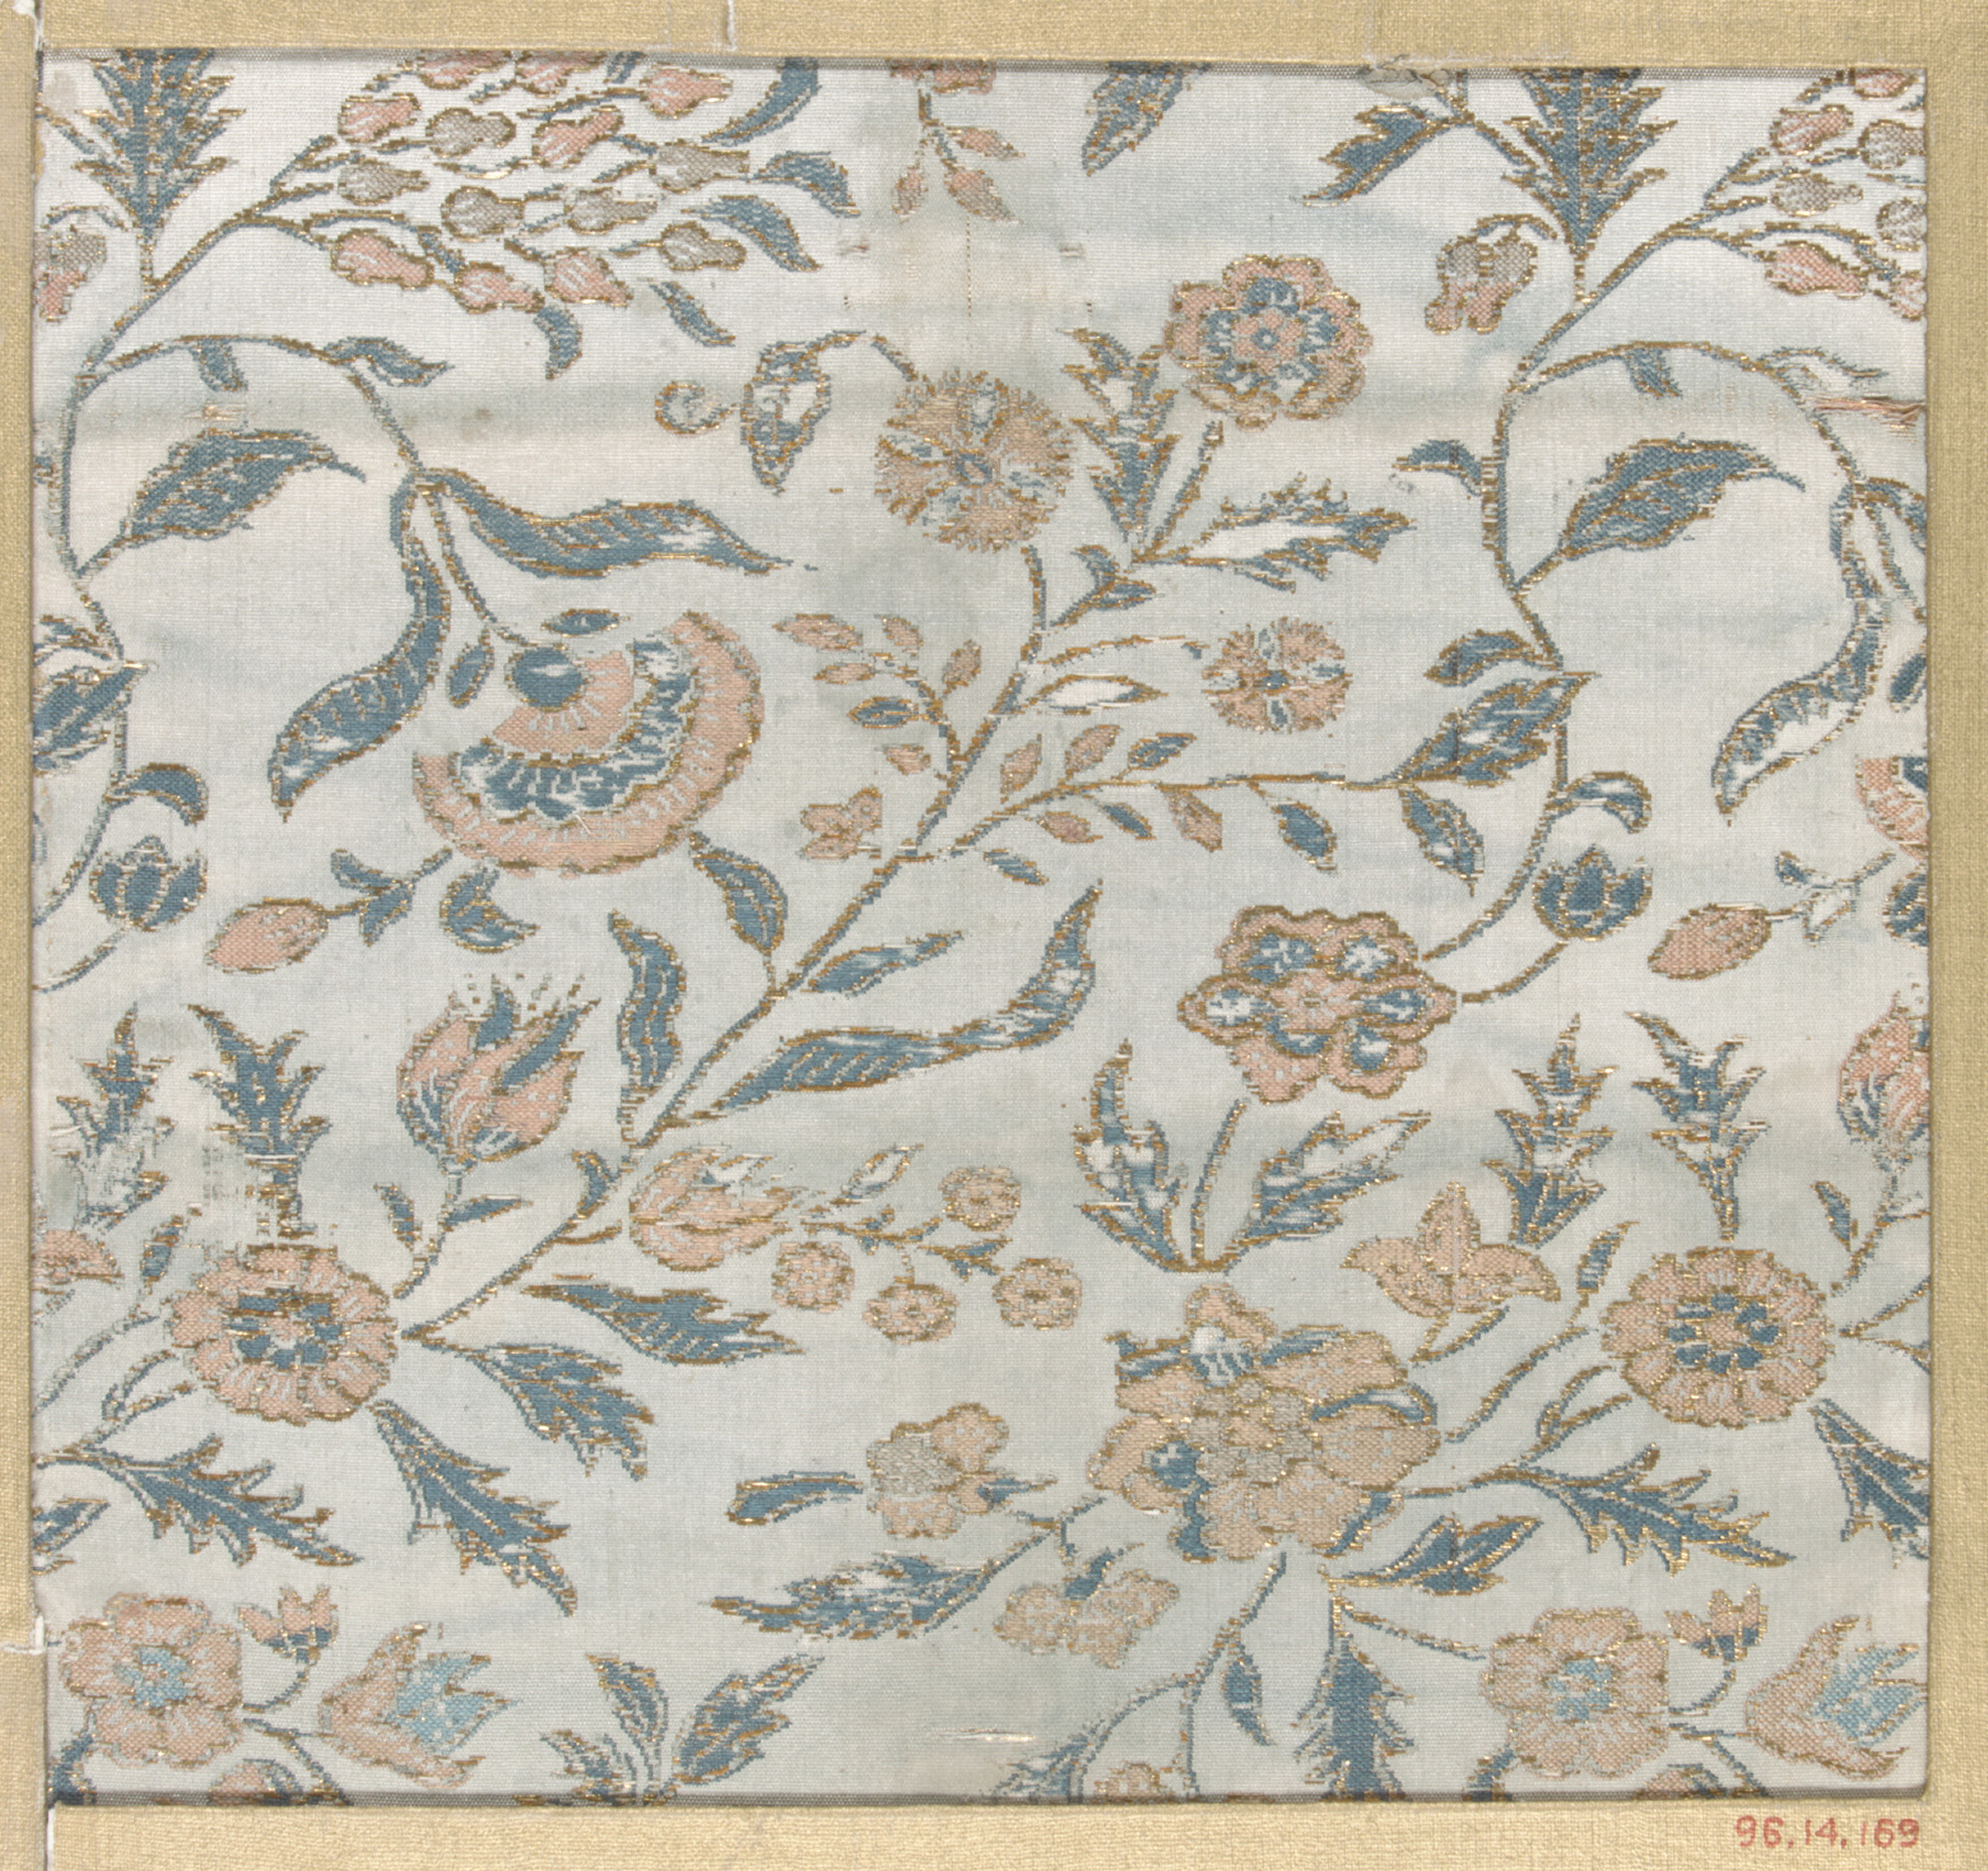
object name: piece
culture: japanese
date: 1701-1900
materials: silk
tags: leaves